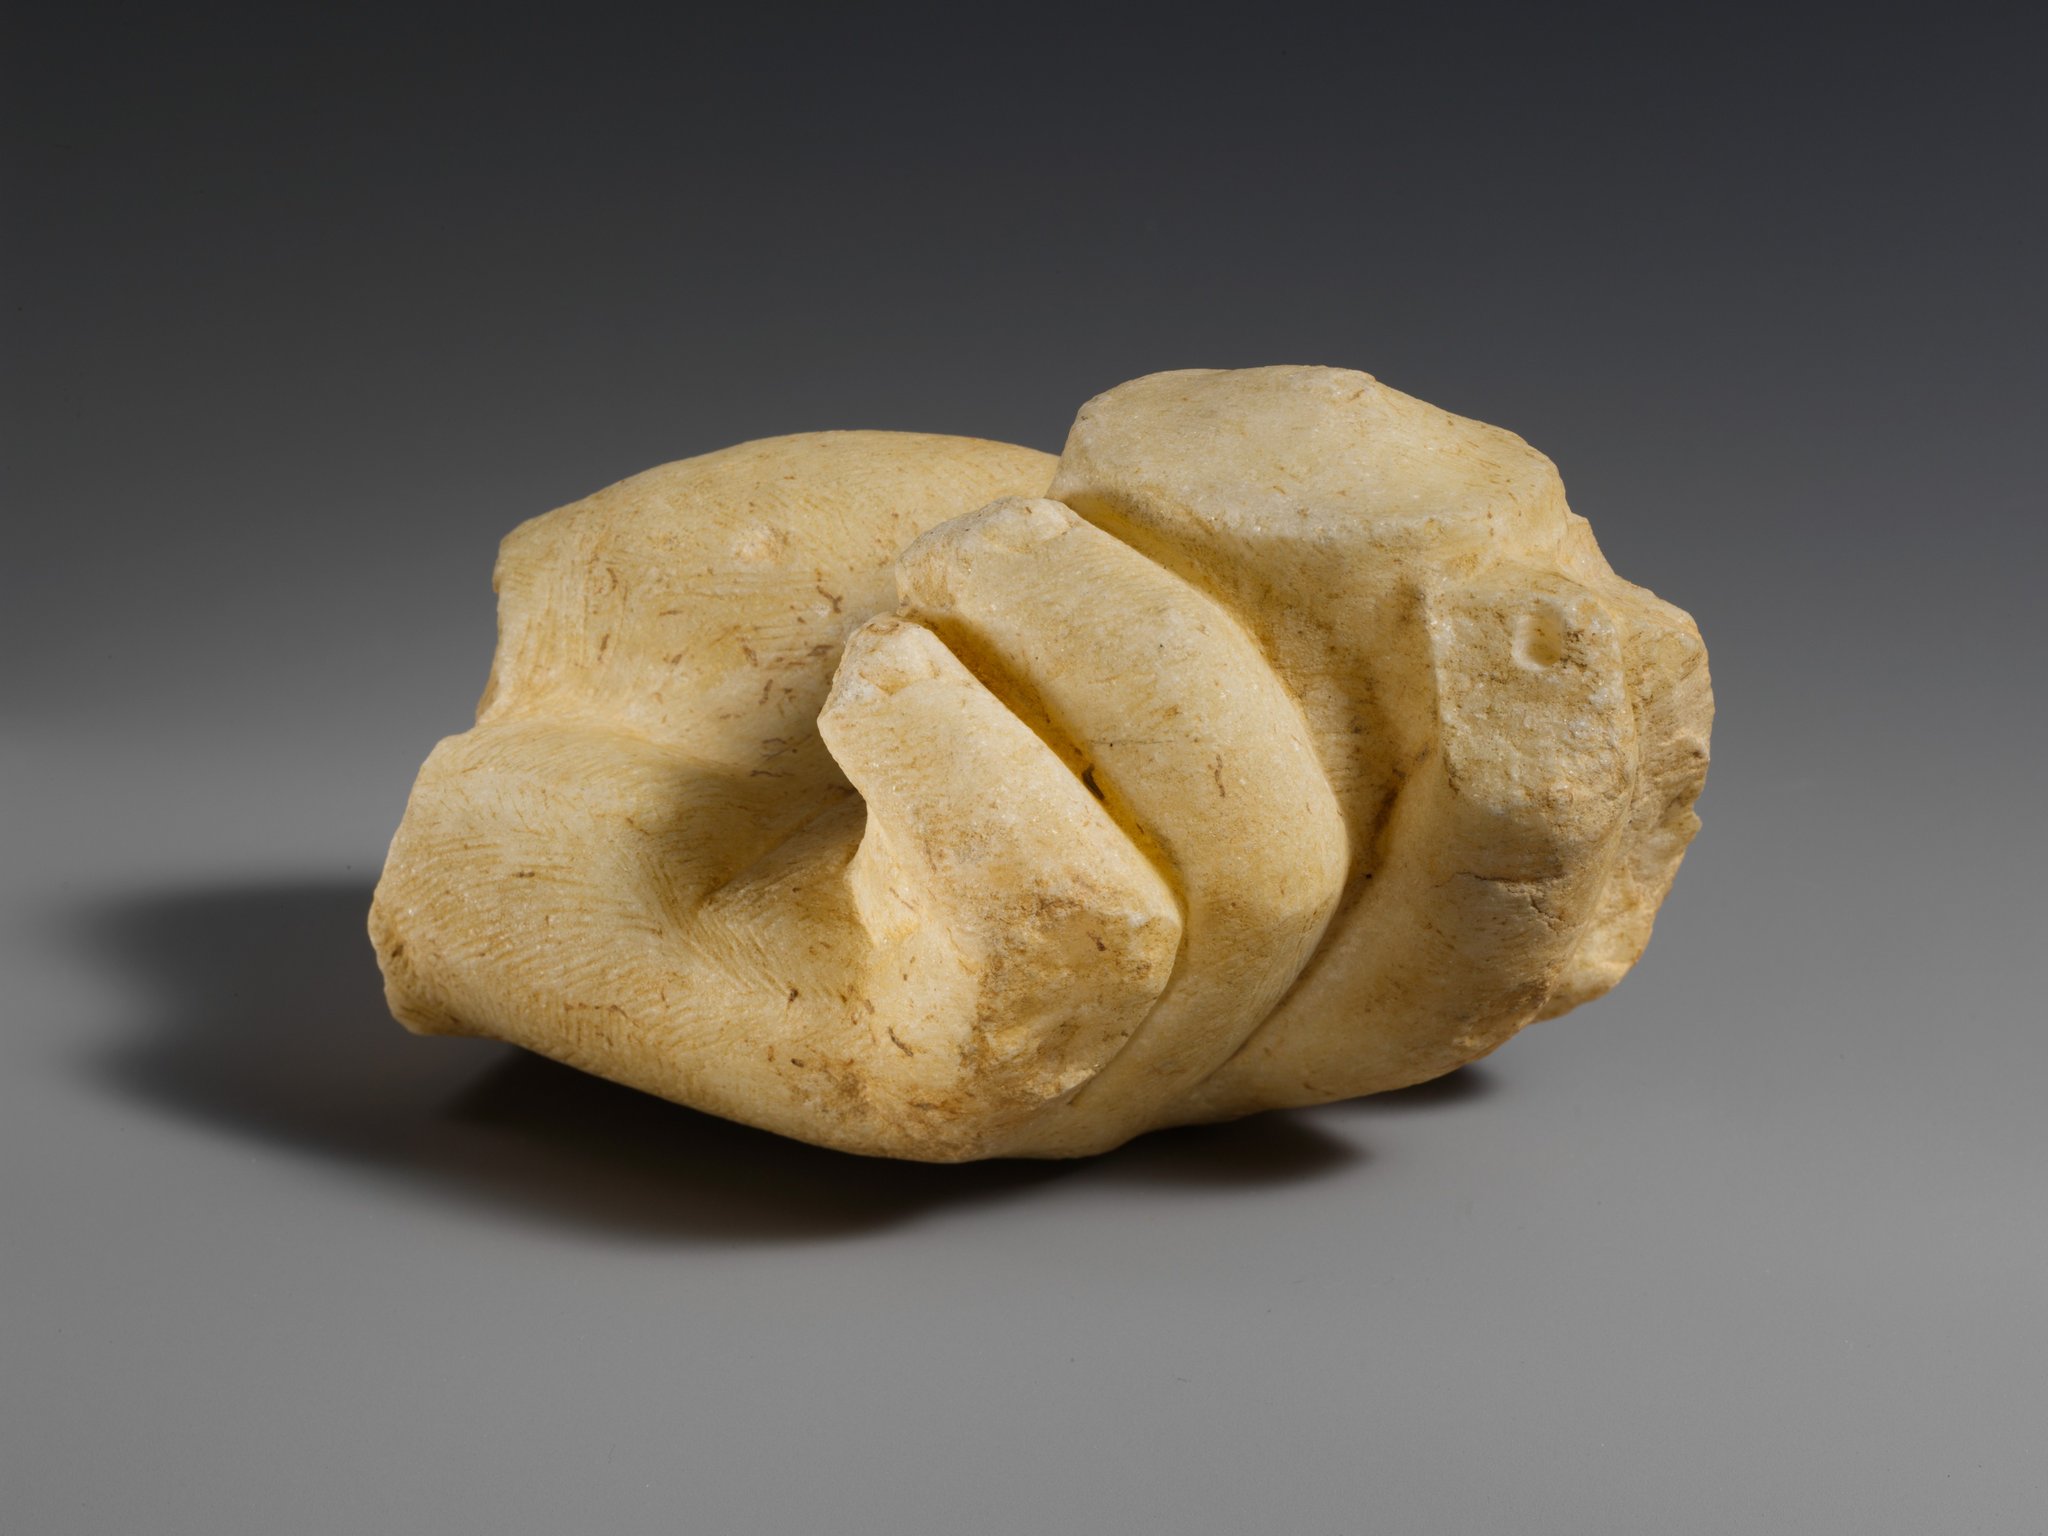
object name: hand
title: Marble left hand holding a box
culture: greek or roman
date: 100 BCE-200 CE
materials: marble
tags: hands